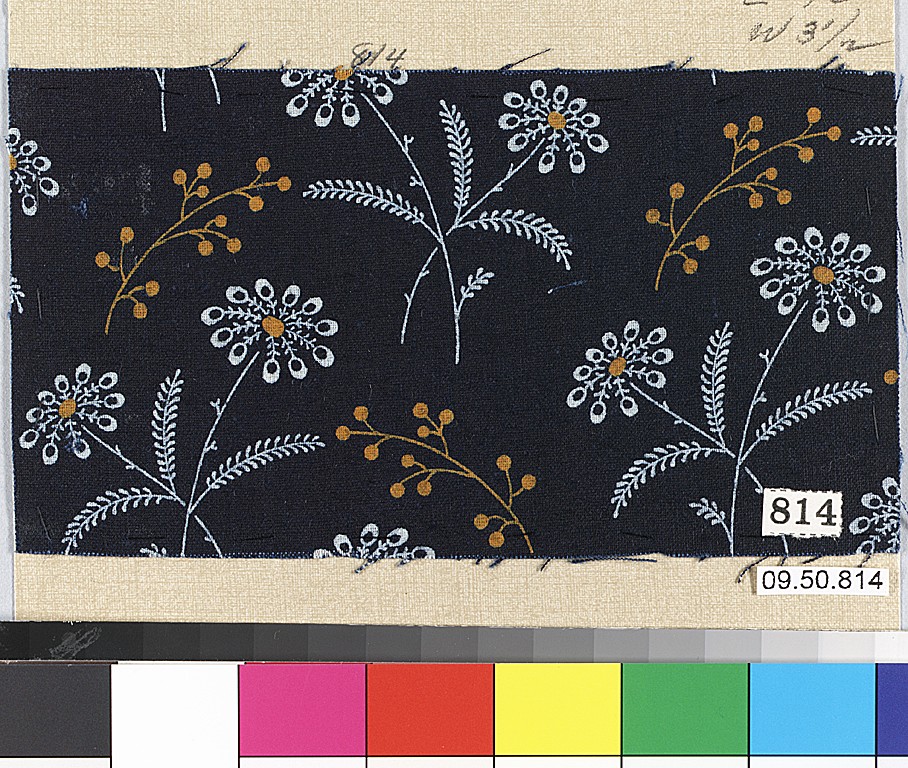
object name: piece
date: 1801-1900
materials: cotton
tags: flowers,leaves